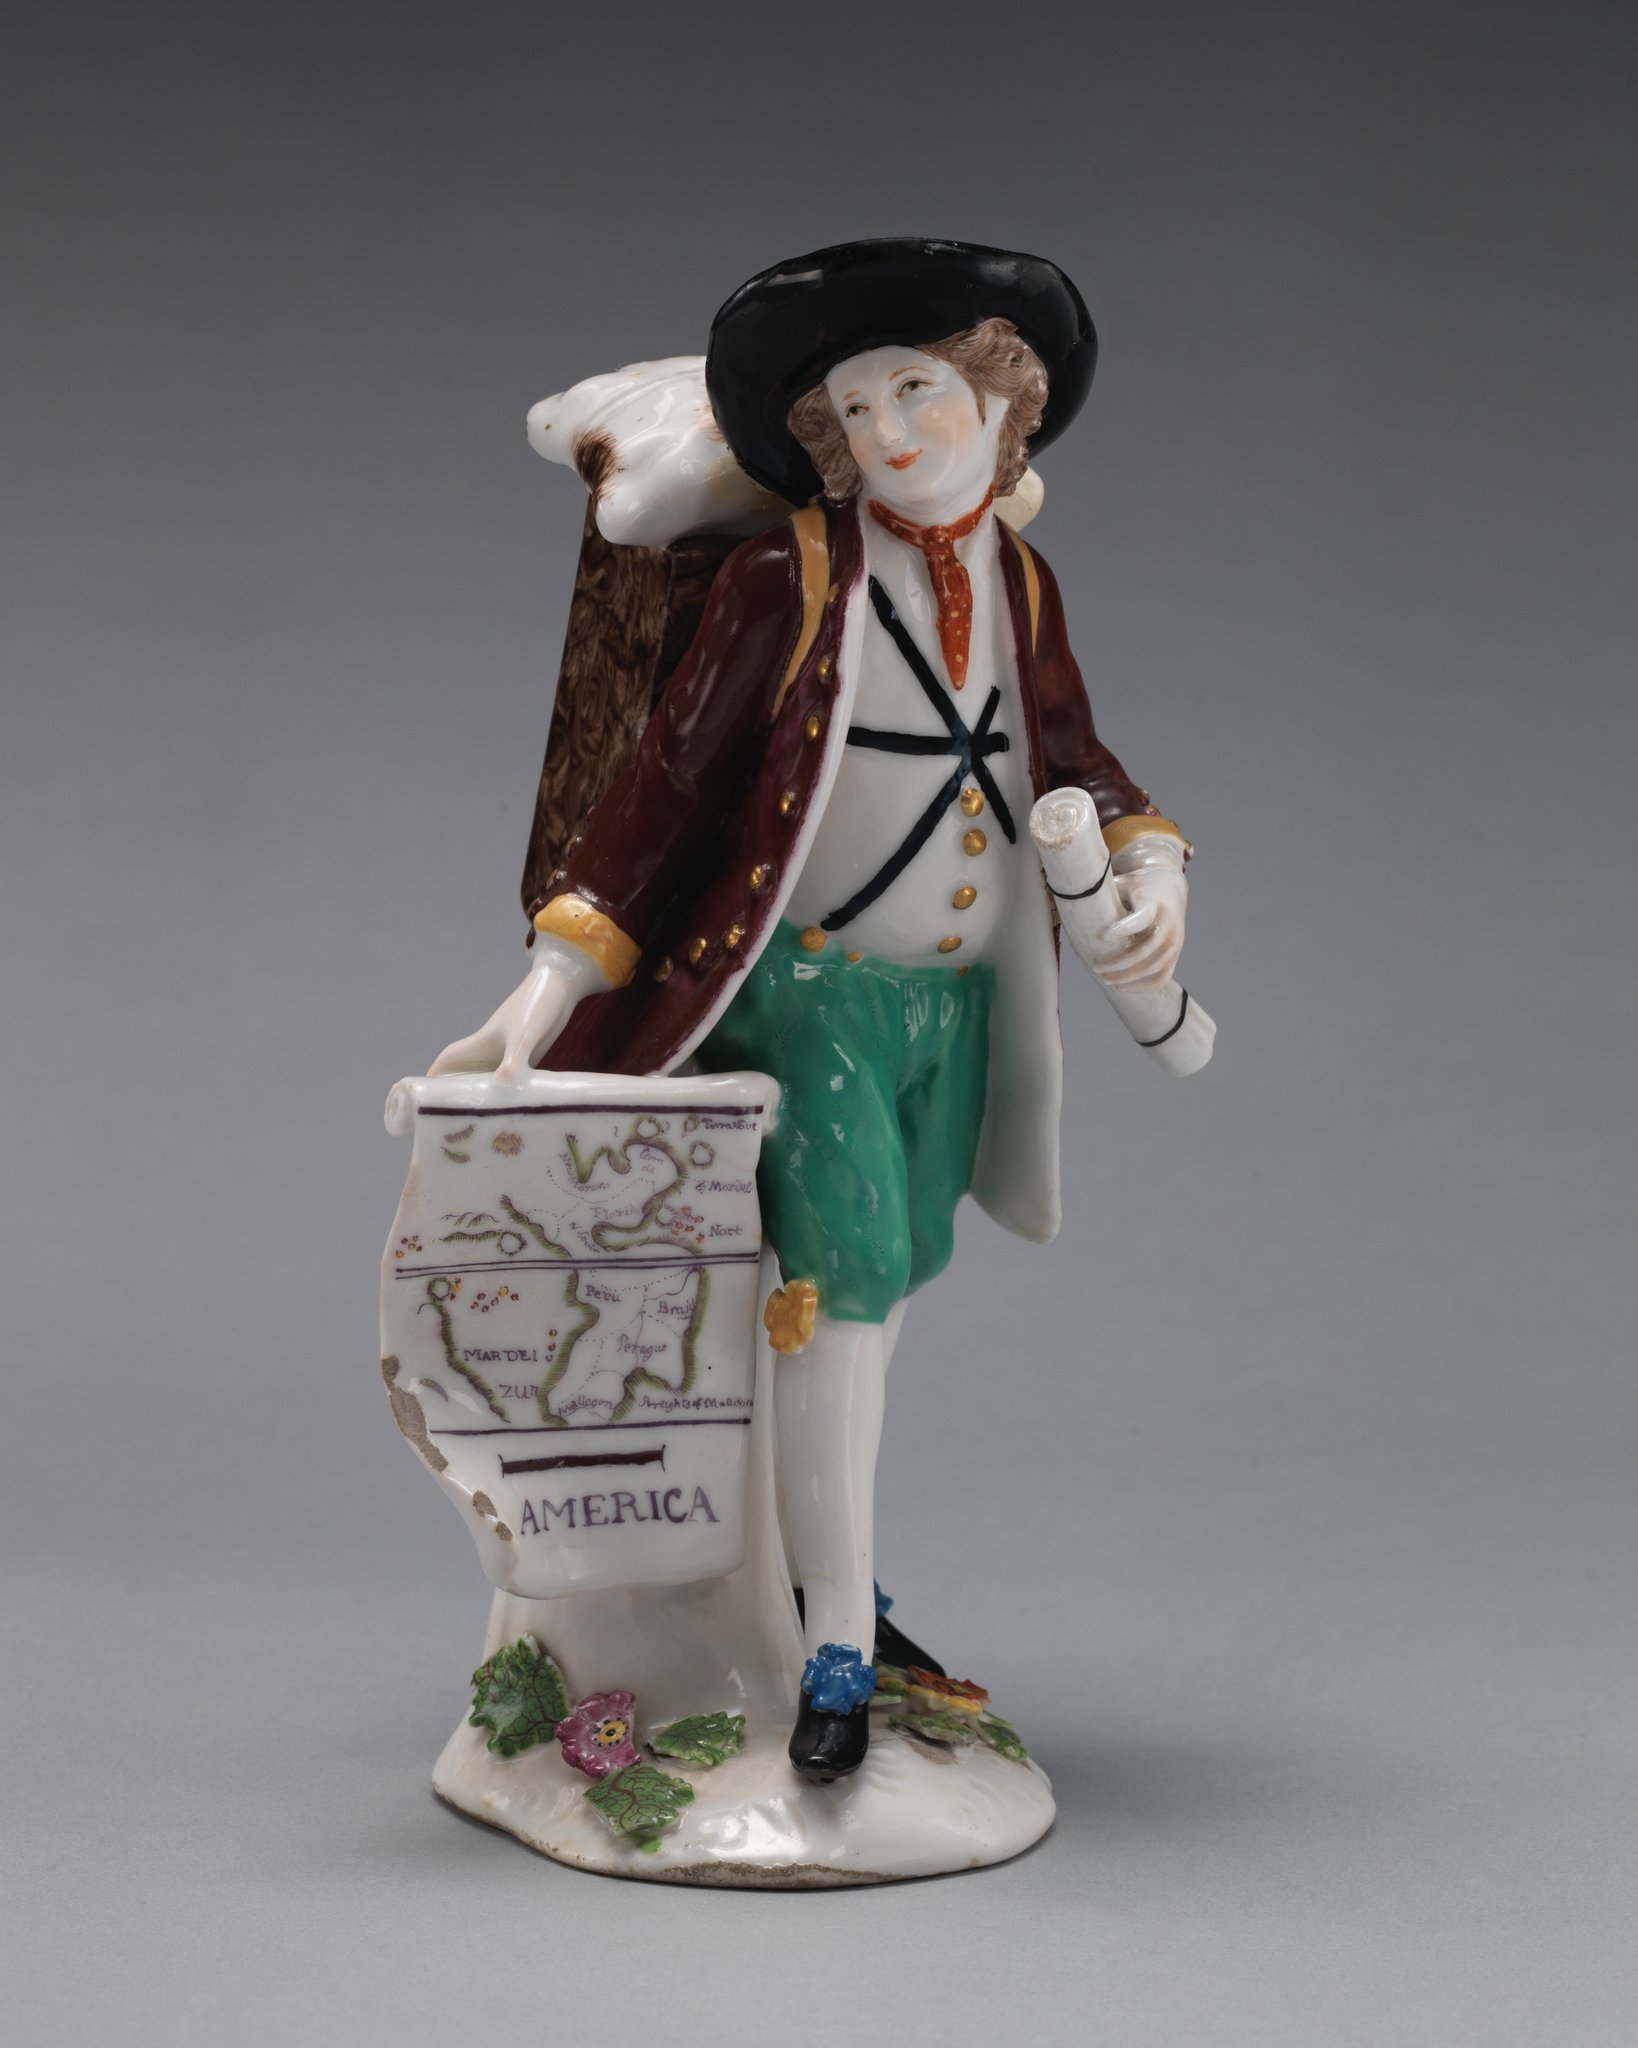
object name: figure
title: Map seller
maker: chelsea porcelain manufactory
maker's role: factory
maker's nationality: british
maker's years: 1744-1784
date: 1755-1756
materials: soft paste porcelain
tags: men,maps